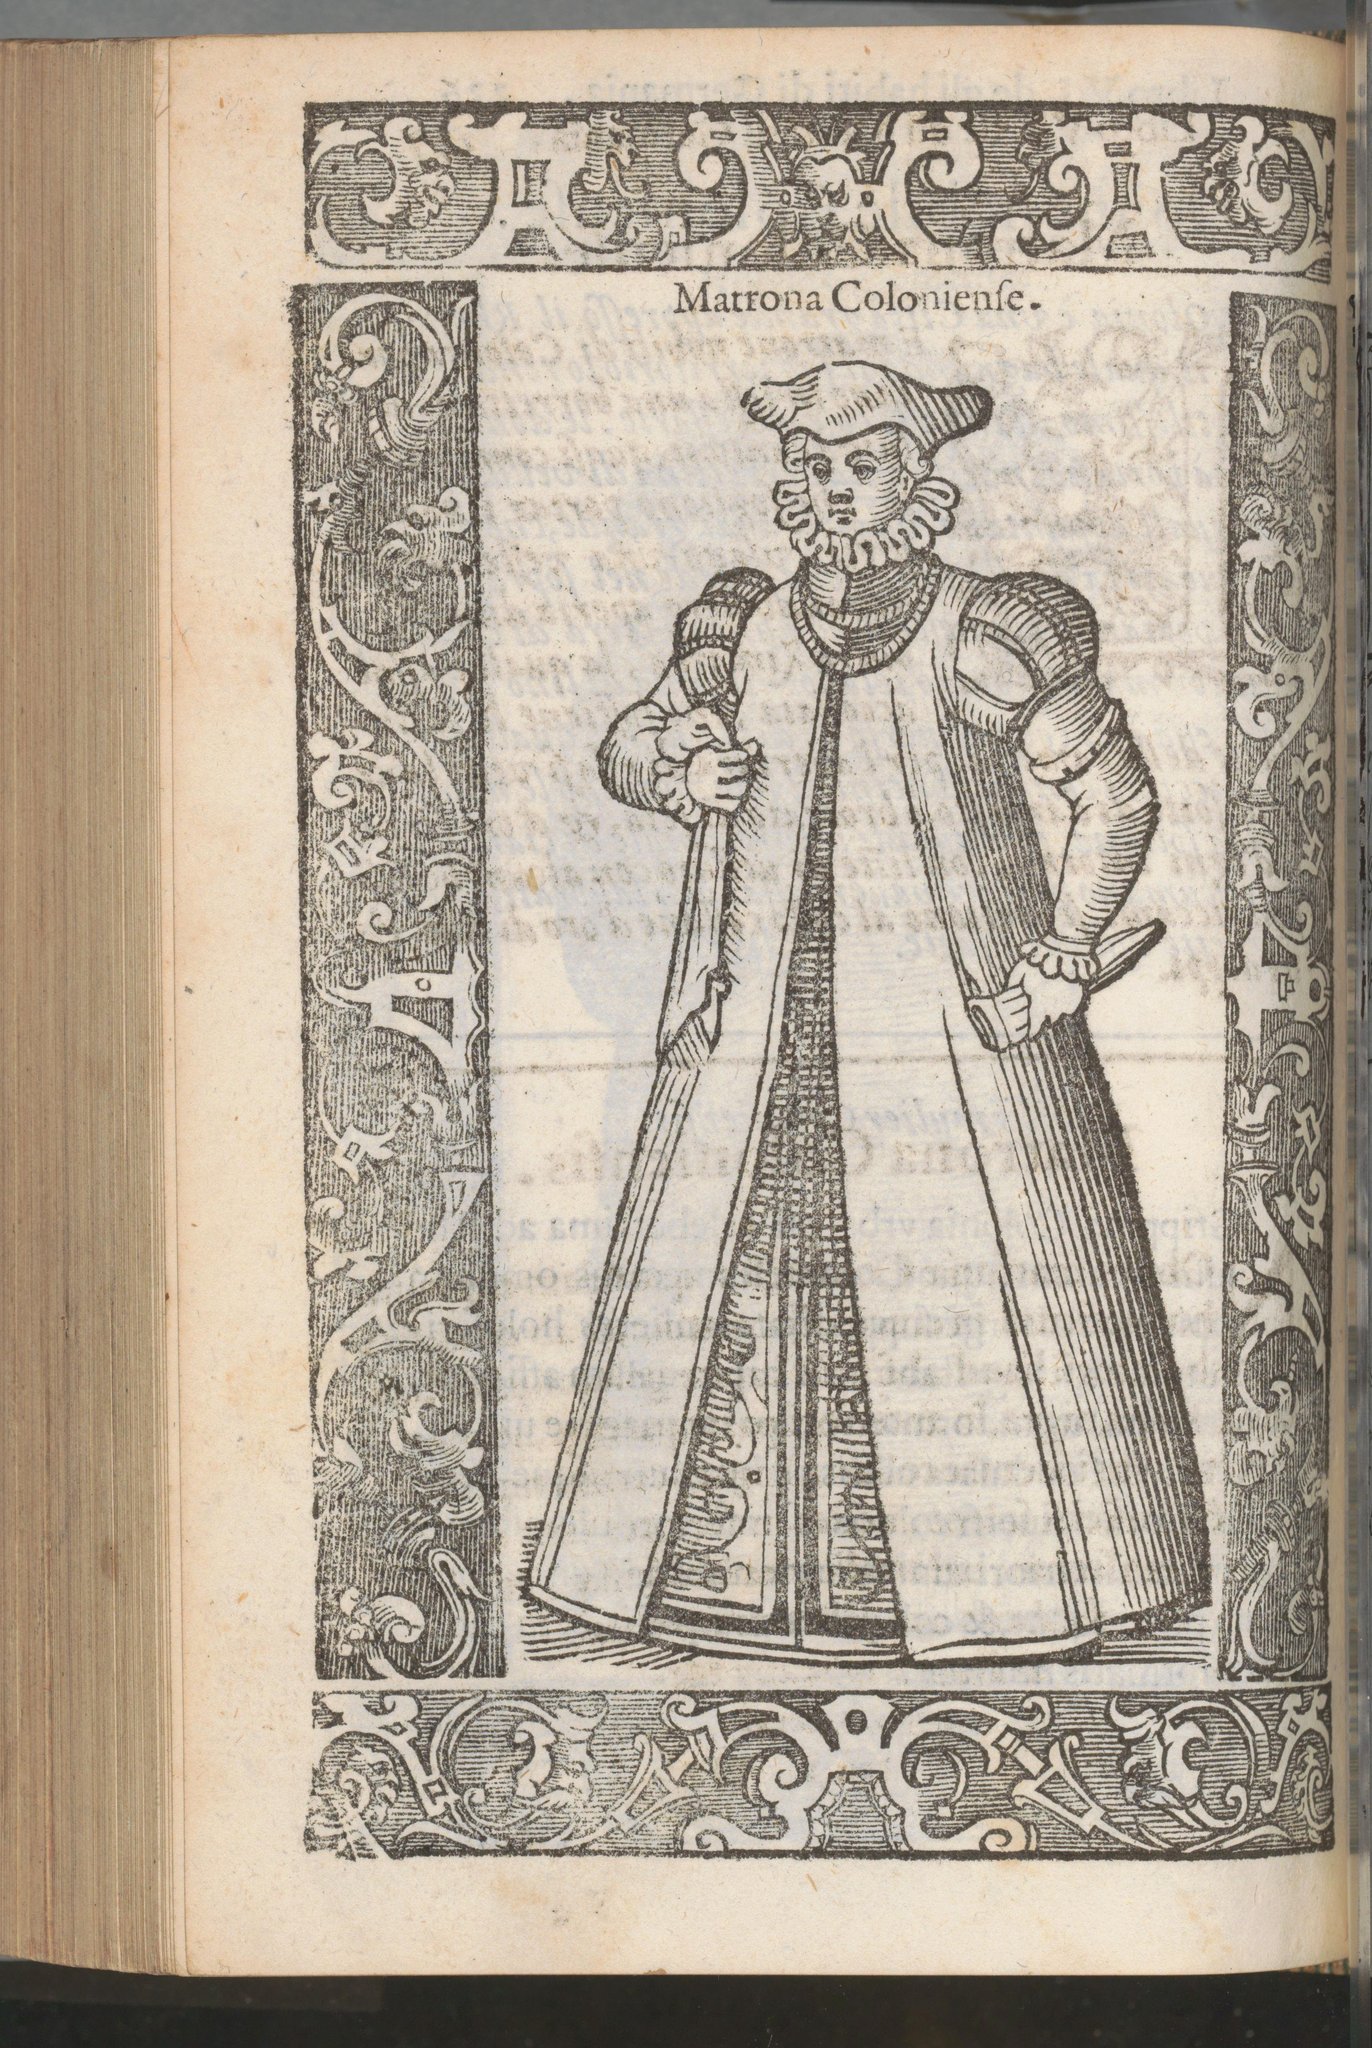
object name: costume print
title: Matrona Coloniense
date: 1598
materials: paper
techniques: woodcut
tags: fashion plates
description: Getrouwde vrouw uit Keulen, fluwelen muts met uitstaande punten. Lang overkleed dat van voren open valt. Kleine plooikraag.